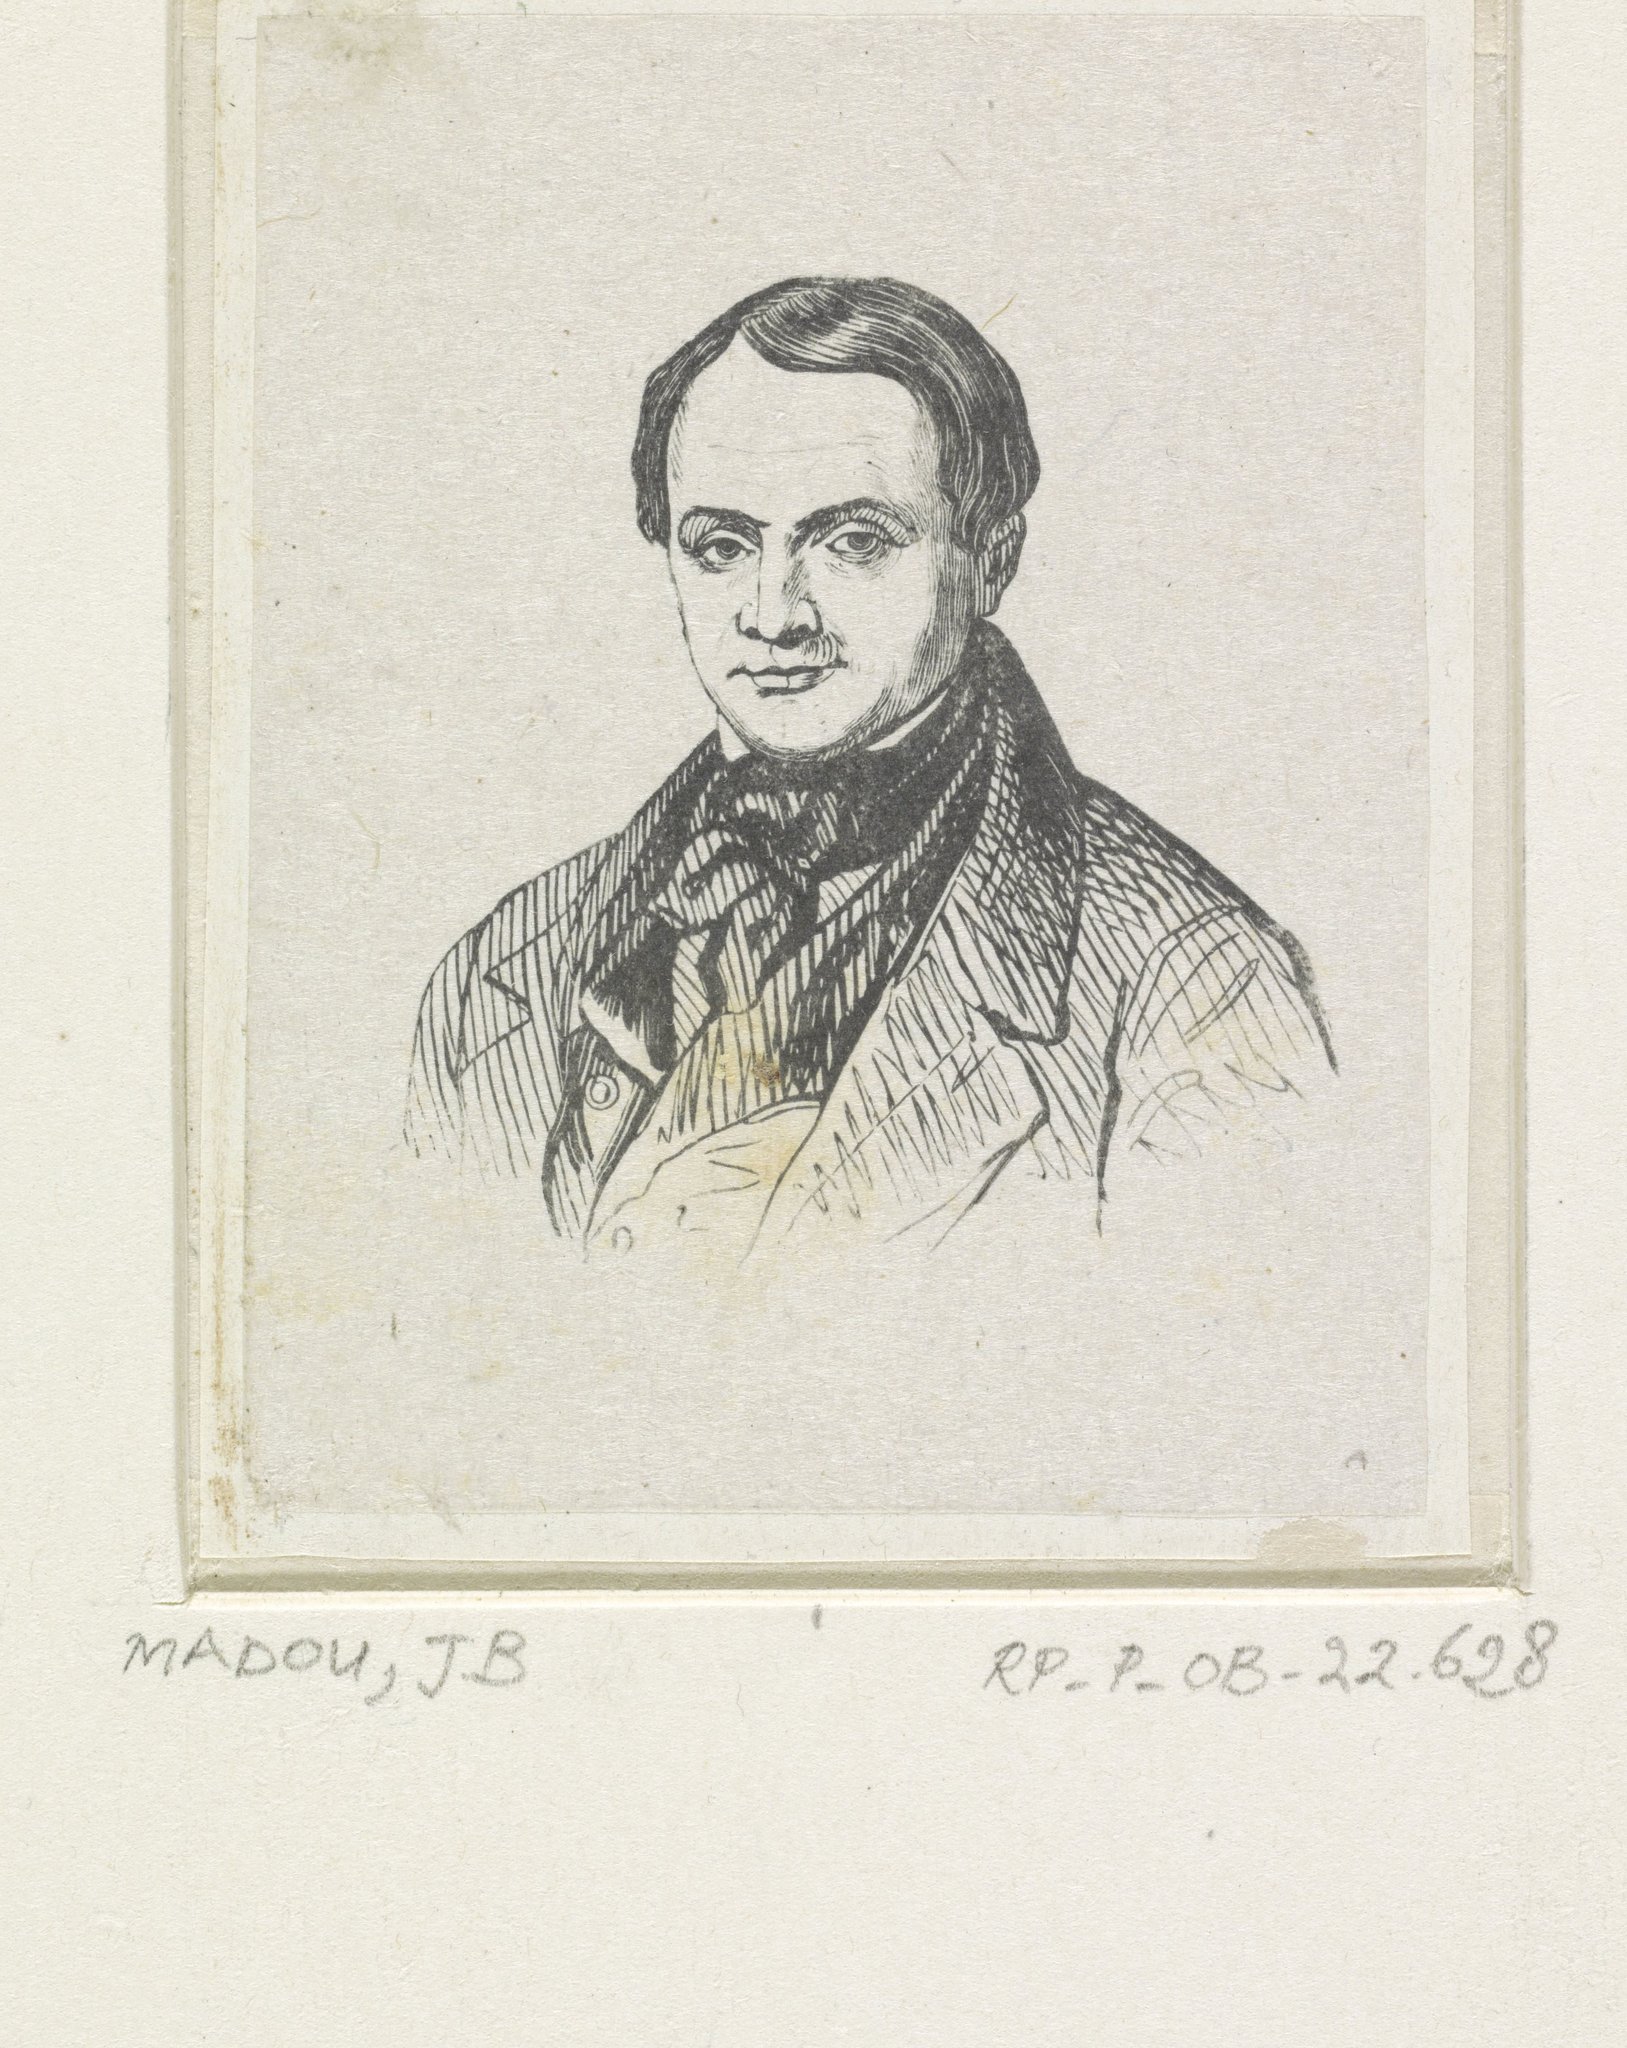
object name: print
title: Portret van Jean Baptiste Madou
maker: Anonymous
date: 1806-1927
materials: paper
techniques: engraving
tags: brussels, painter, print maker, draughtsman, jean baptiste madou, historical persons, portrait, self-portrait of artist